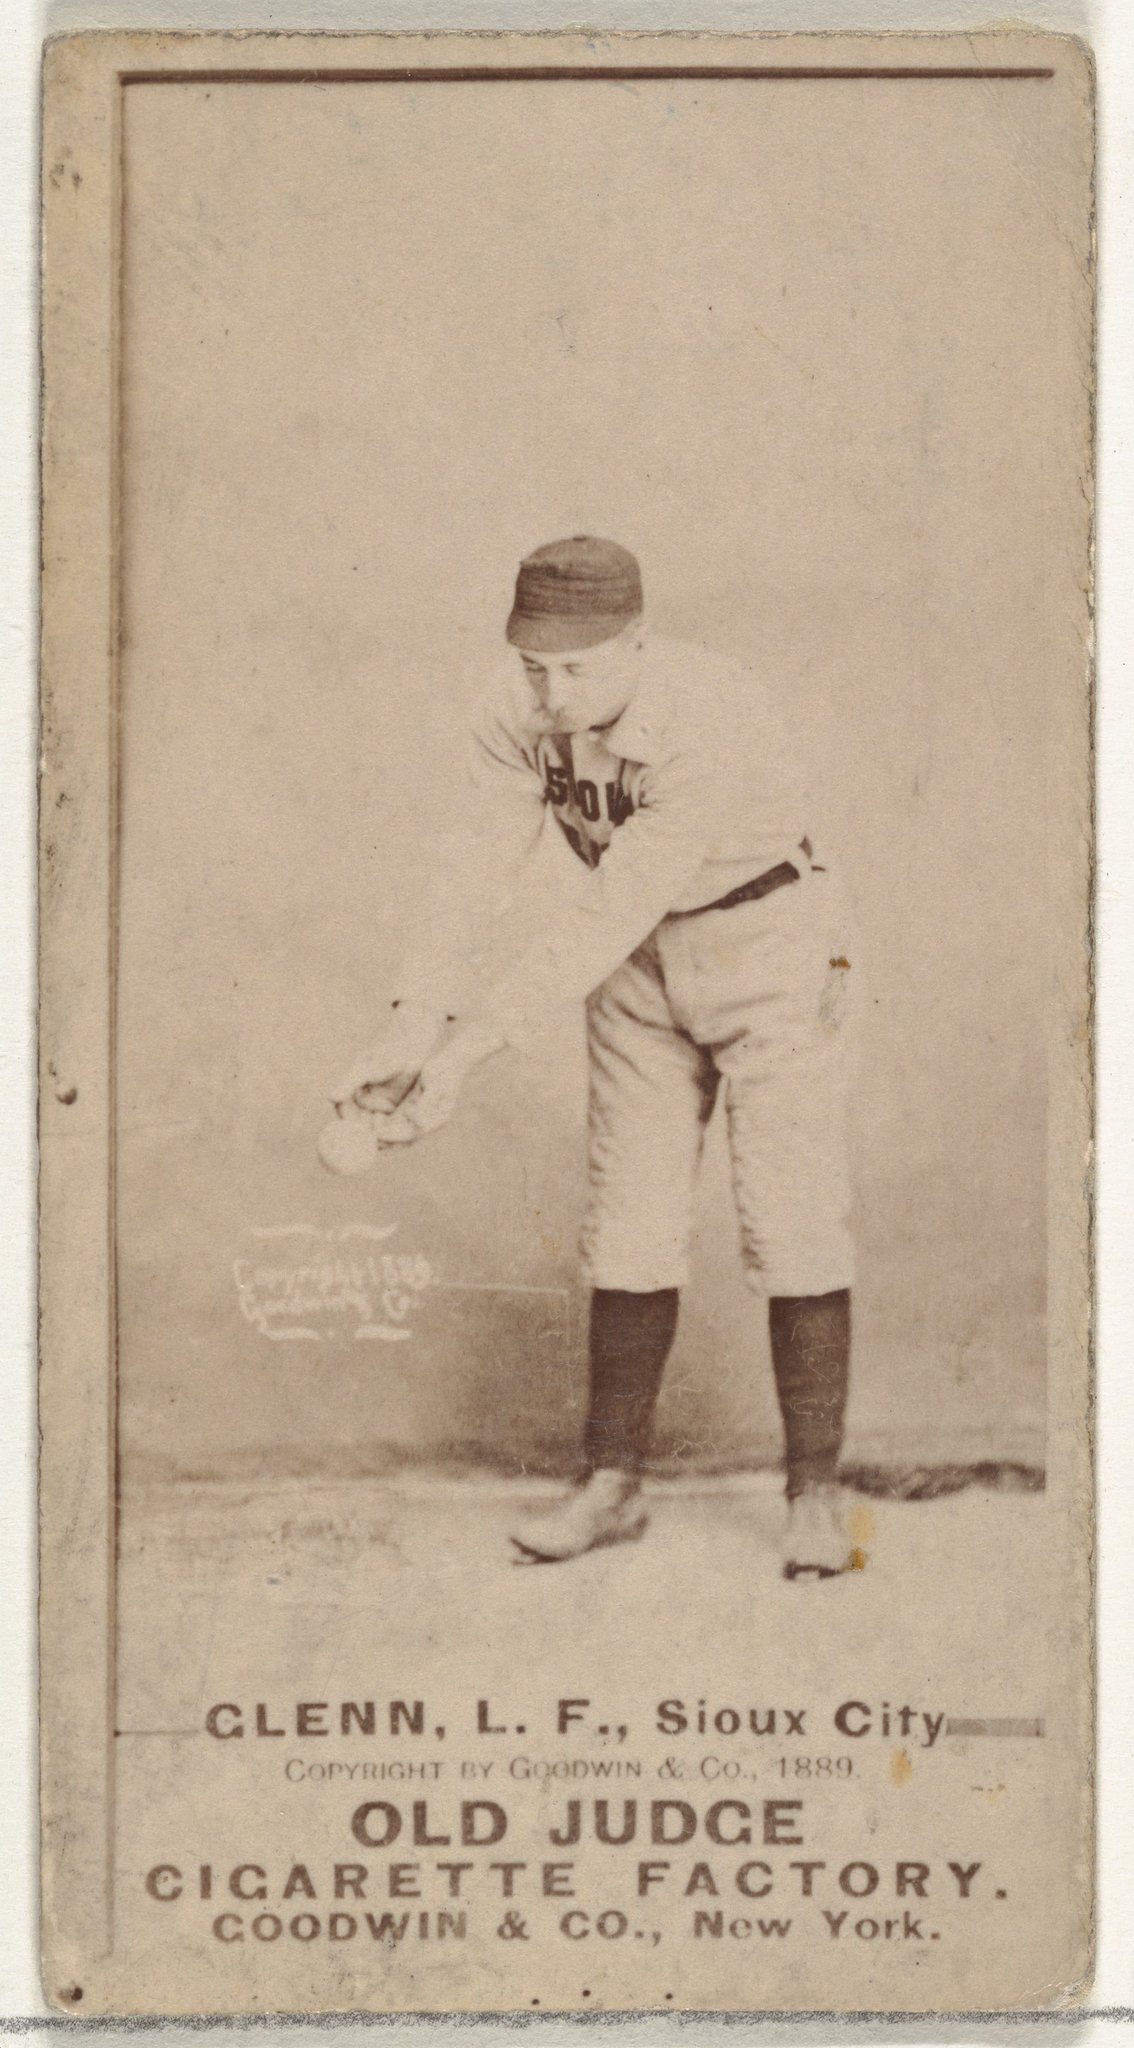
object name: baseball card, photograph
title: Edward C. "Mouse" Glenn, Left Field, Sioux City Corn Huskers, from the Old Judge series (N172) for Old Judge Cigarettes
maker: goodwin & company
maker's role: publisher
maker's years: 1850-1950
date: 1889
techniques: albumen silver print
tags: men,portraits,baseball,athletes